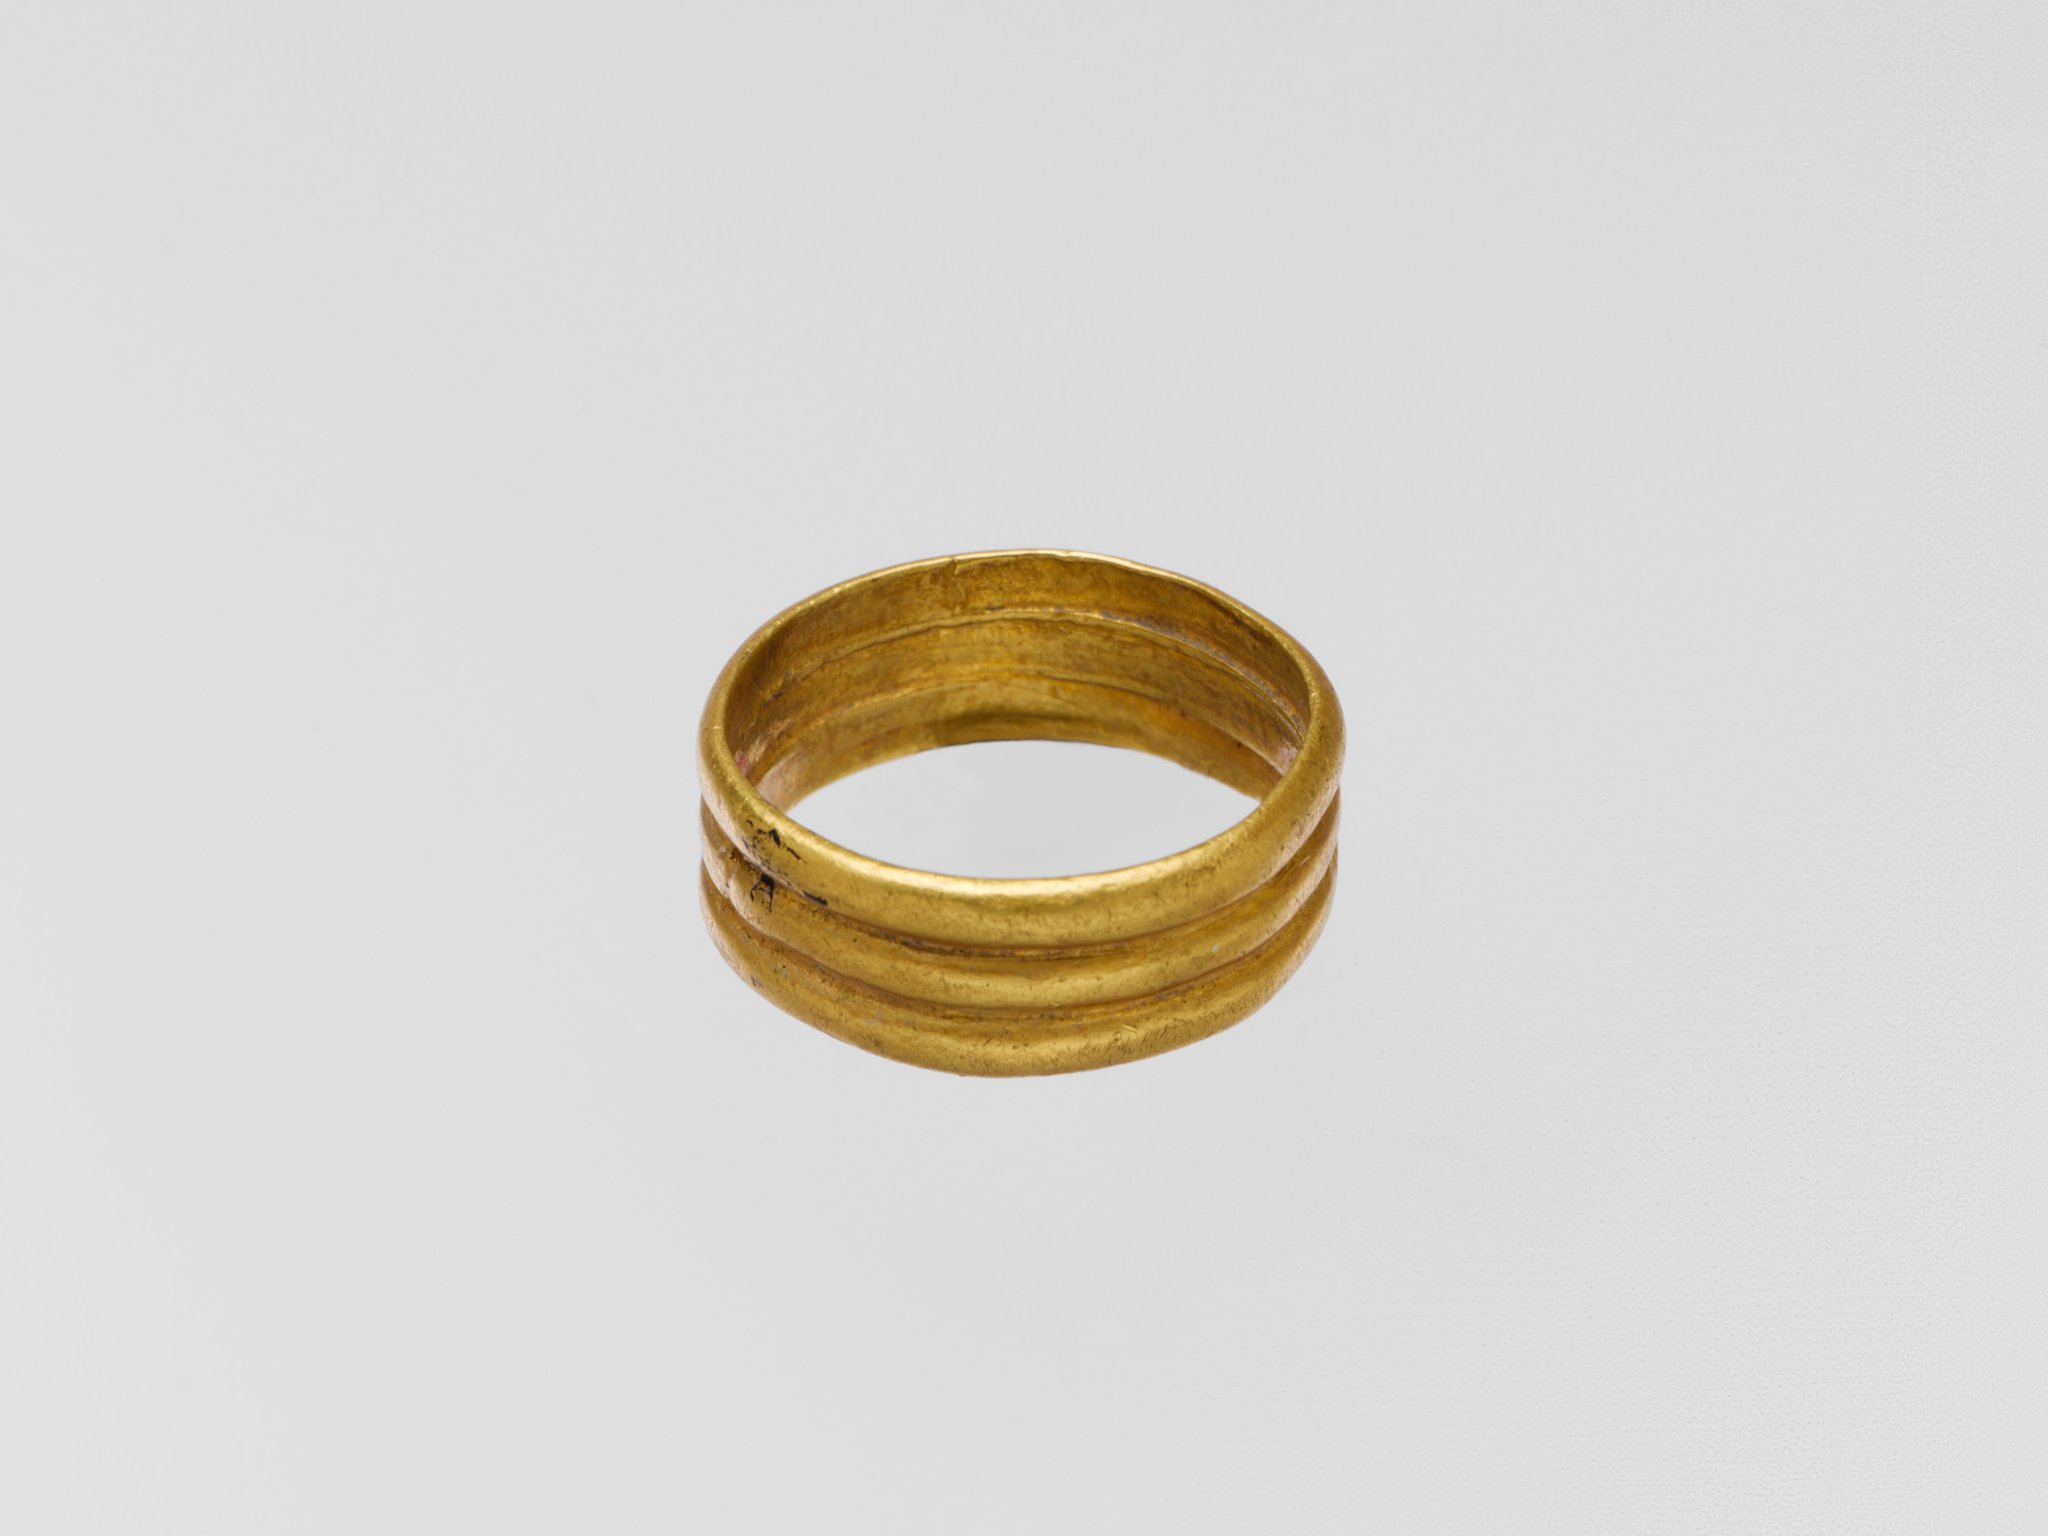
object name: ring, three joined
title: Gold ring with three horizontal ribs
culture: cypriot or greek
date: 800-601 BCE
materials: gold